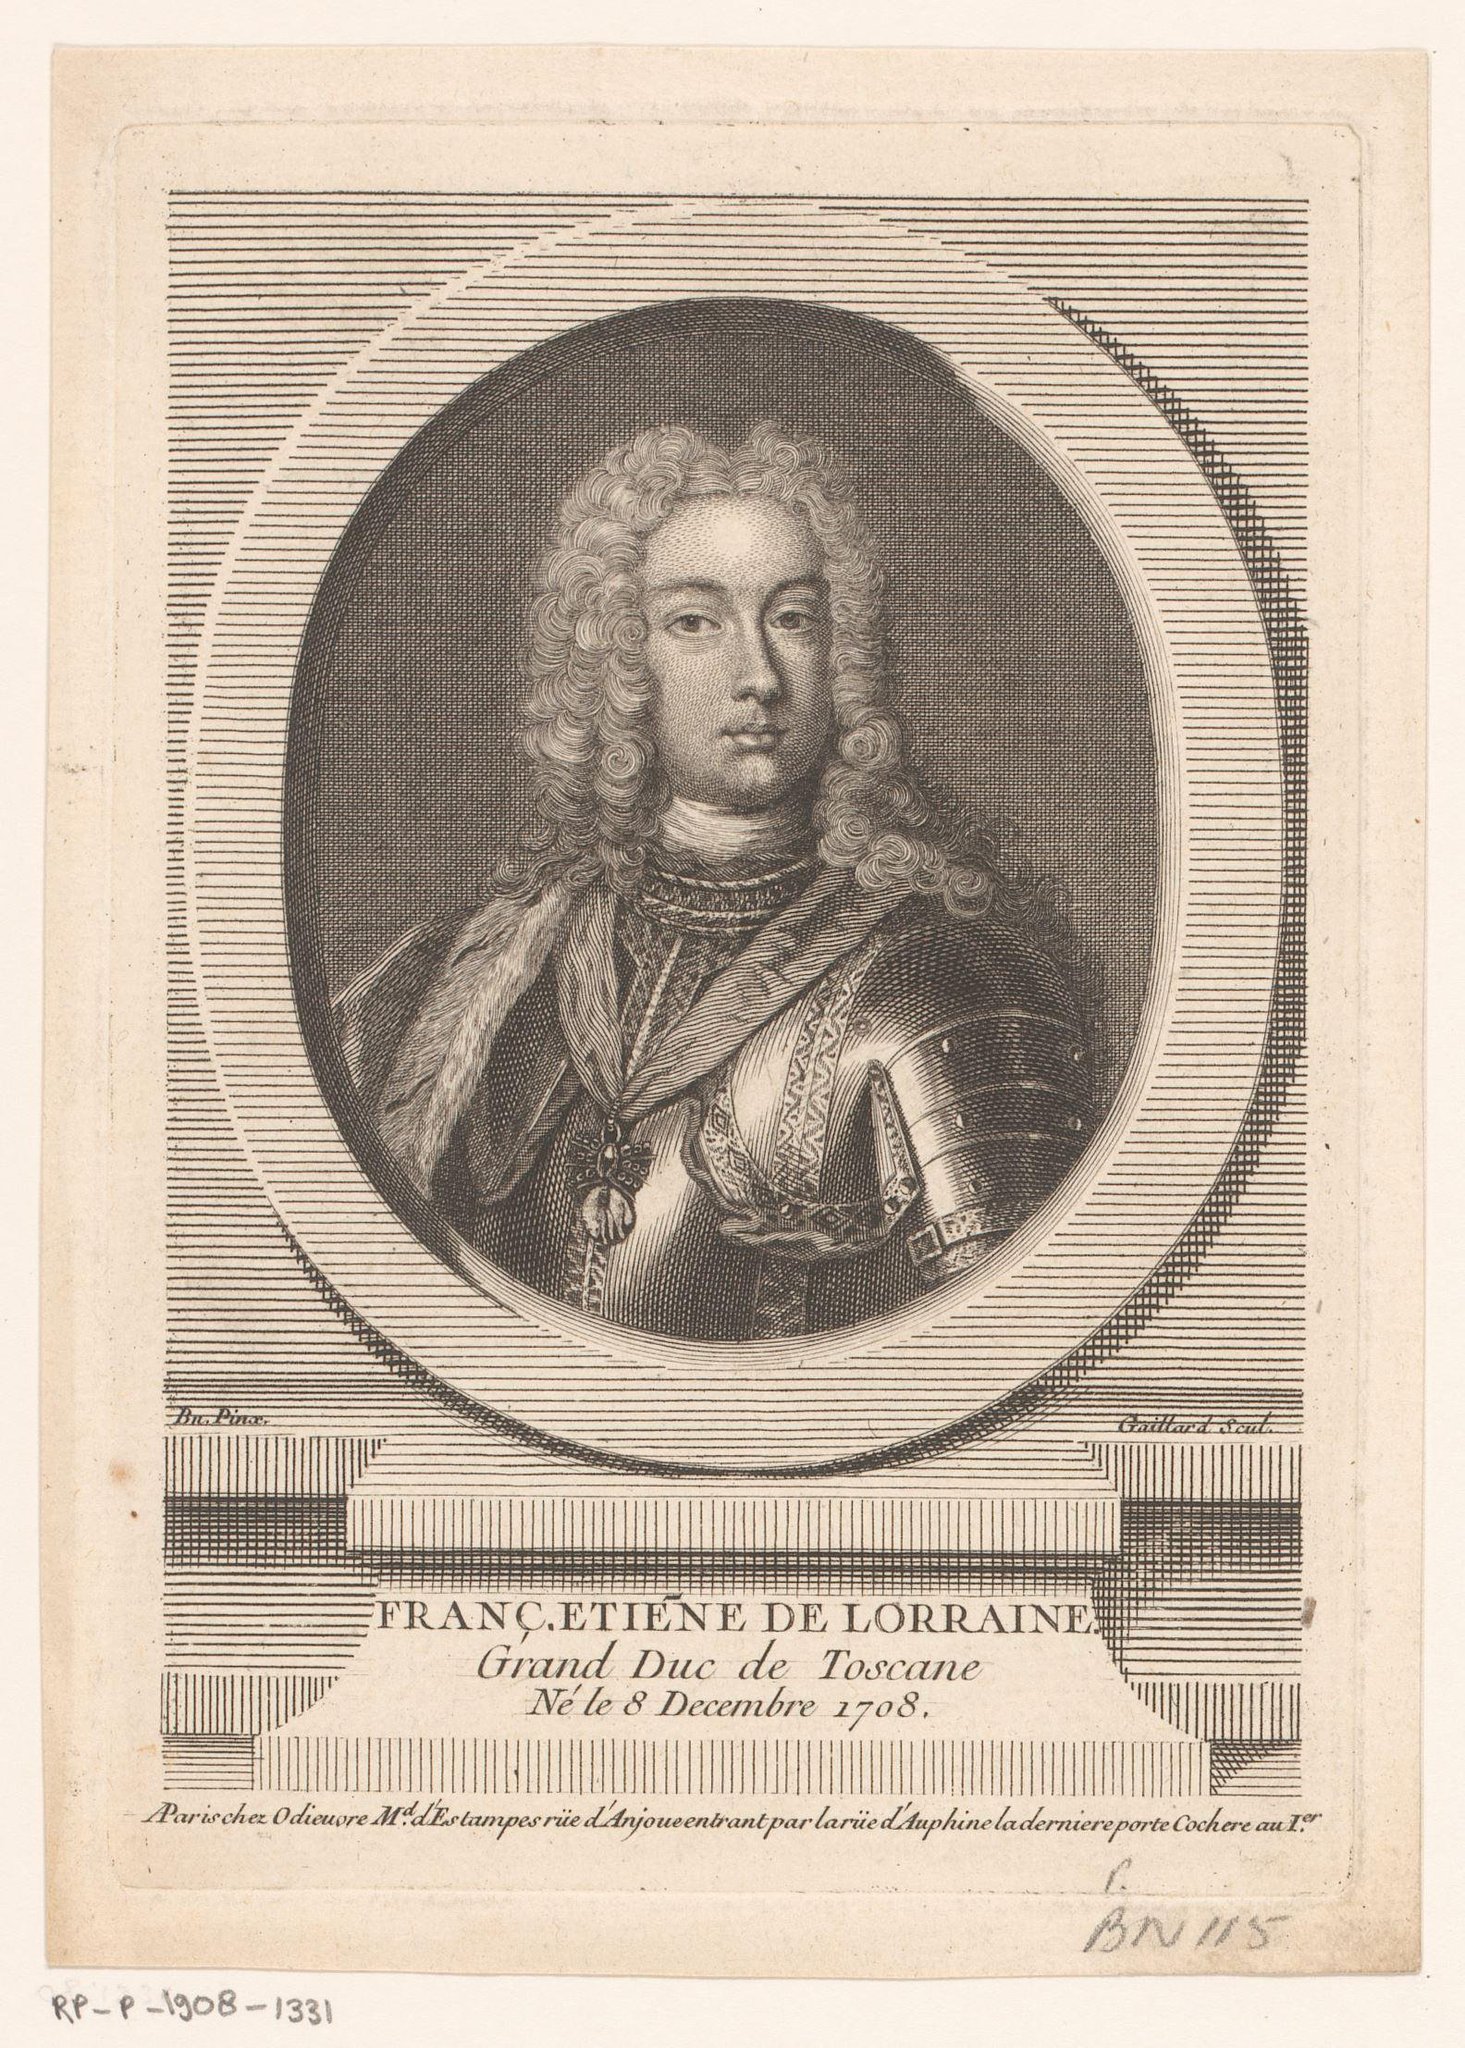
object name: print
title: Portret van Anne Dacier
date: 1755-1765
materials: paper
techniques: engraving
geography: paris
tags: paris, historical persons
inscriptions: collector's mark: Lugt 2228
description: Mogelijk prent uit: Dreux du Radier, Jean-François. L'Europe illustré, contenant l'histoire abregée des souverains, des princes, des prélats, des ministres, (...) en Europe: dans le XVe. siècle compris, jusqu'à présent. Parijs: Michel Odieuvre en André-François Le Breton, 1755-1765, dl. 5.